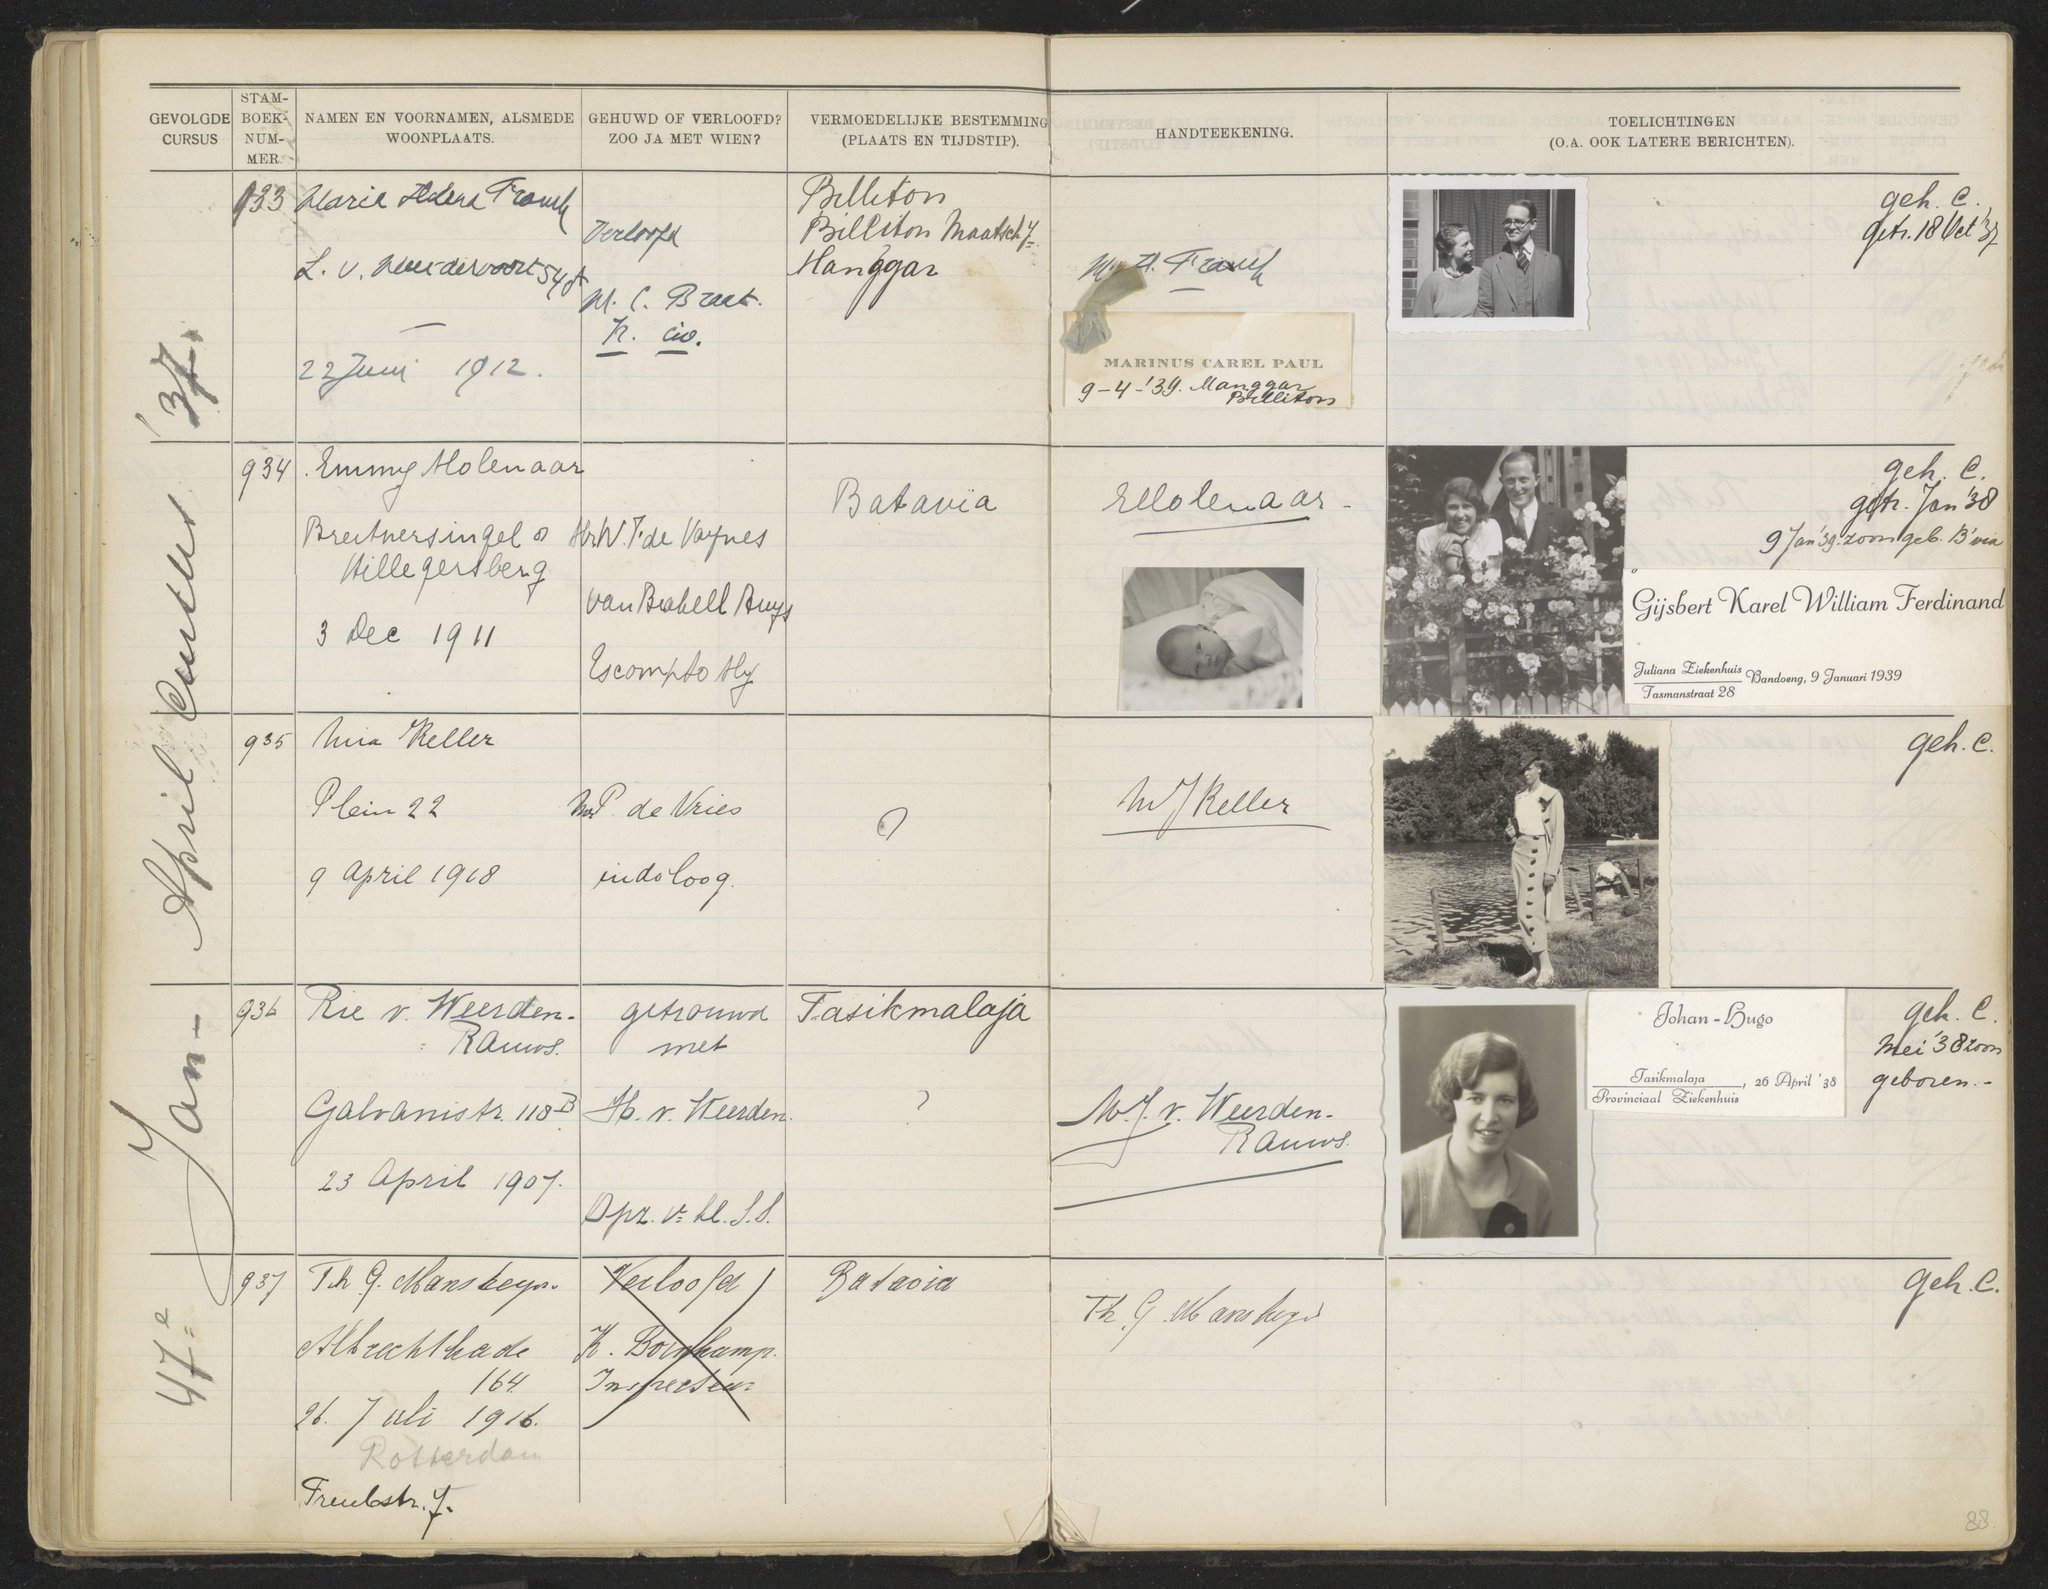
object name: album leaf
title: Blad 88 uit Stamboek van de leerlingen der Koloniale School voor Meisjes en Vrouwen te 's-Gravenhage deel II (1930-1949)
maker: Anonymous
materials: paper, photographic support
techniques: photography, printing, writing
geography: the hague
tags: further education (+ pupil), further education, the hague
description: Twee pagina's met gegevens van de deelnemers aan de 47e driemaandelijkse cursus van januari tot april 1937, stamboeknummers 933 tot en met 937. Onderdeel van Stamboek van de leerlingen der Koloniale School voor Meisjes en Vrouwen te 's-Gravenhage deel II (1930-1949).